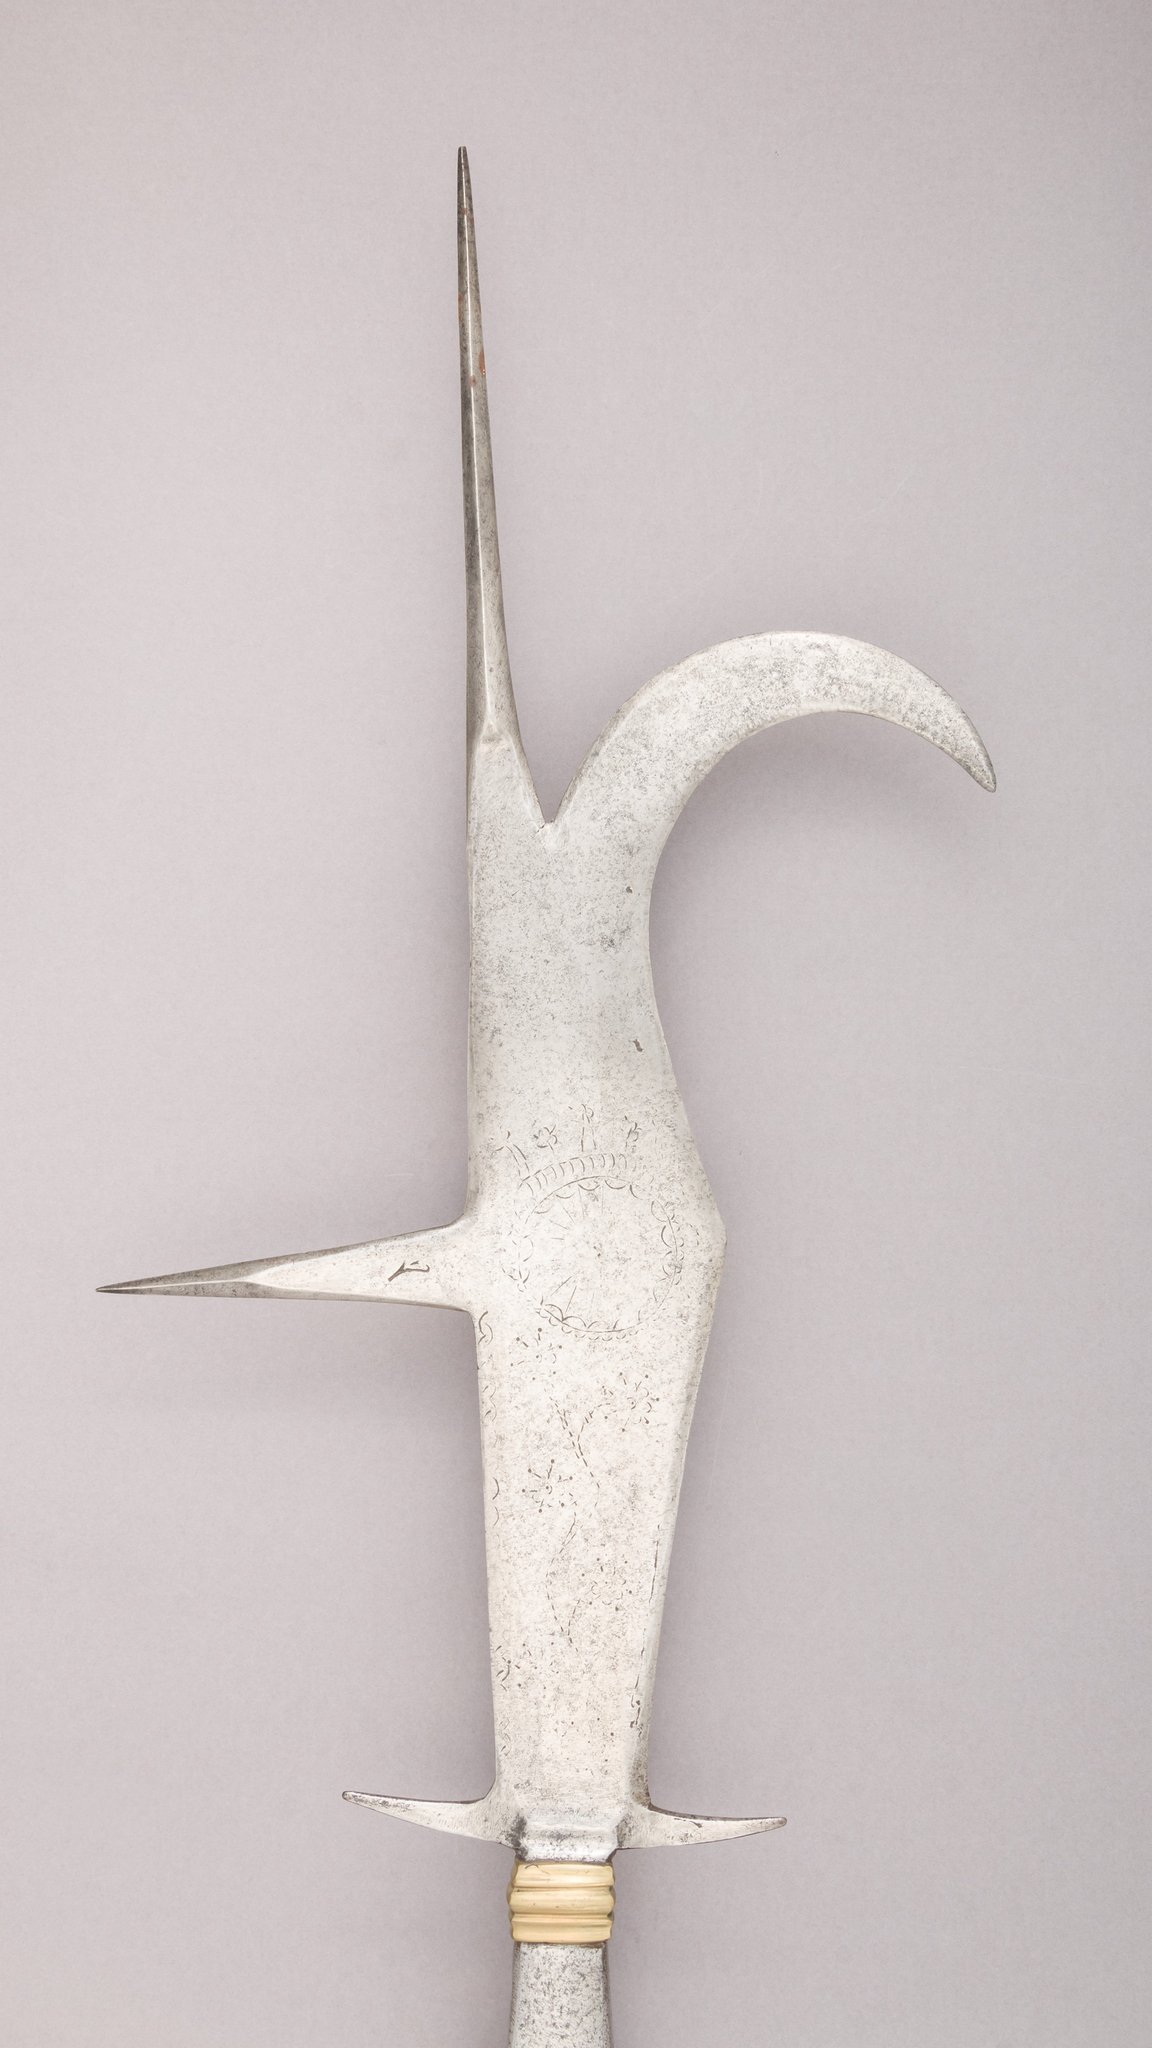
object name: guisarme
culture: italian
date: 1501-1600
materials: brass, steel, textile, wood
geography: italy